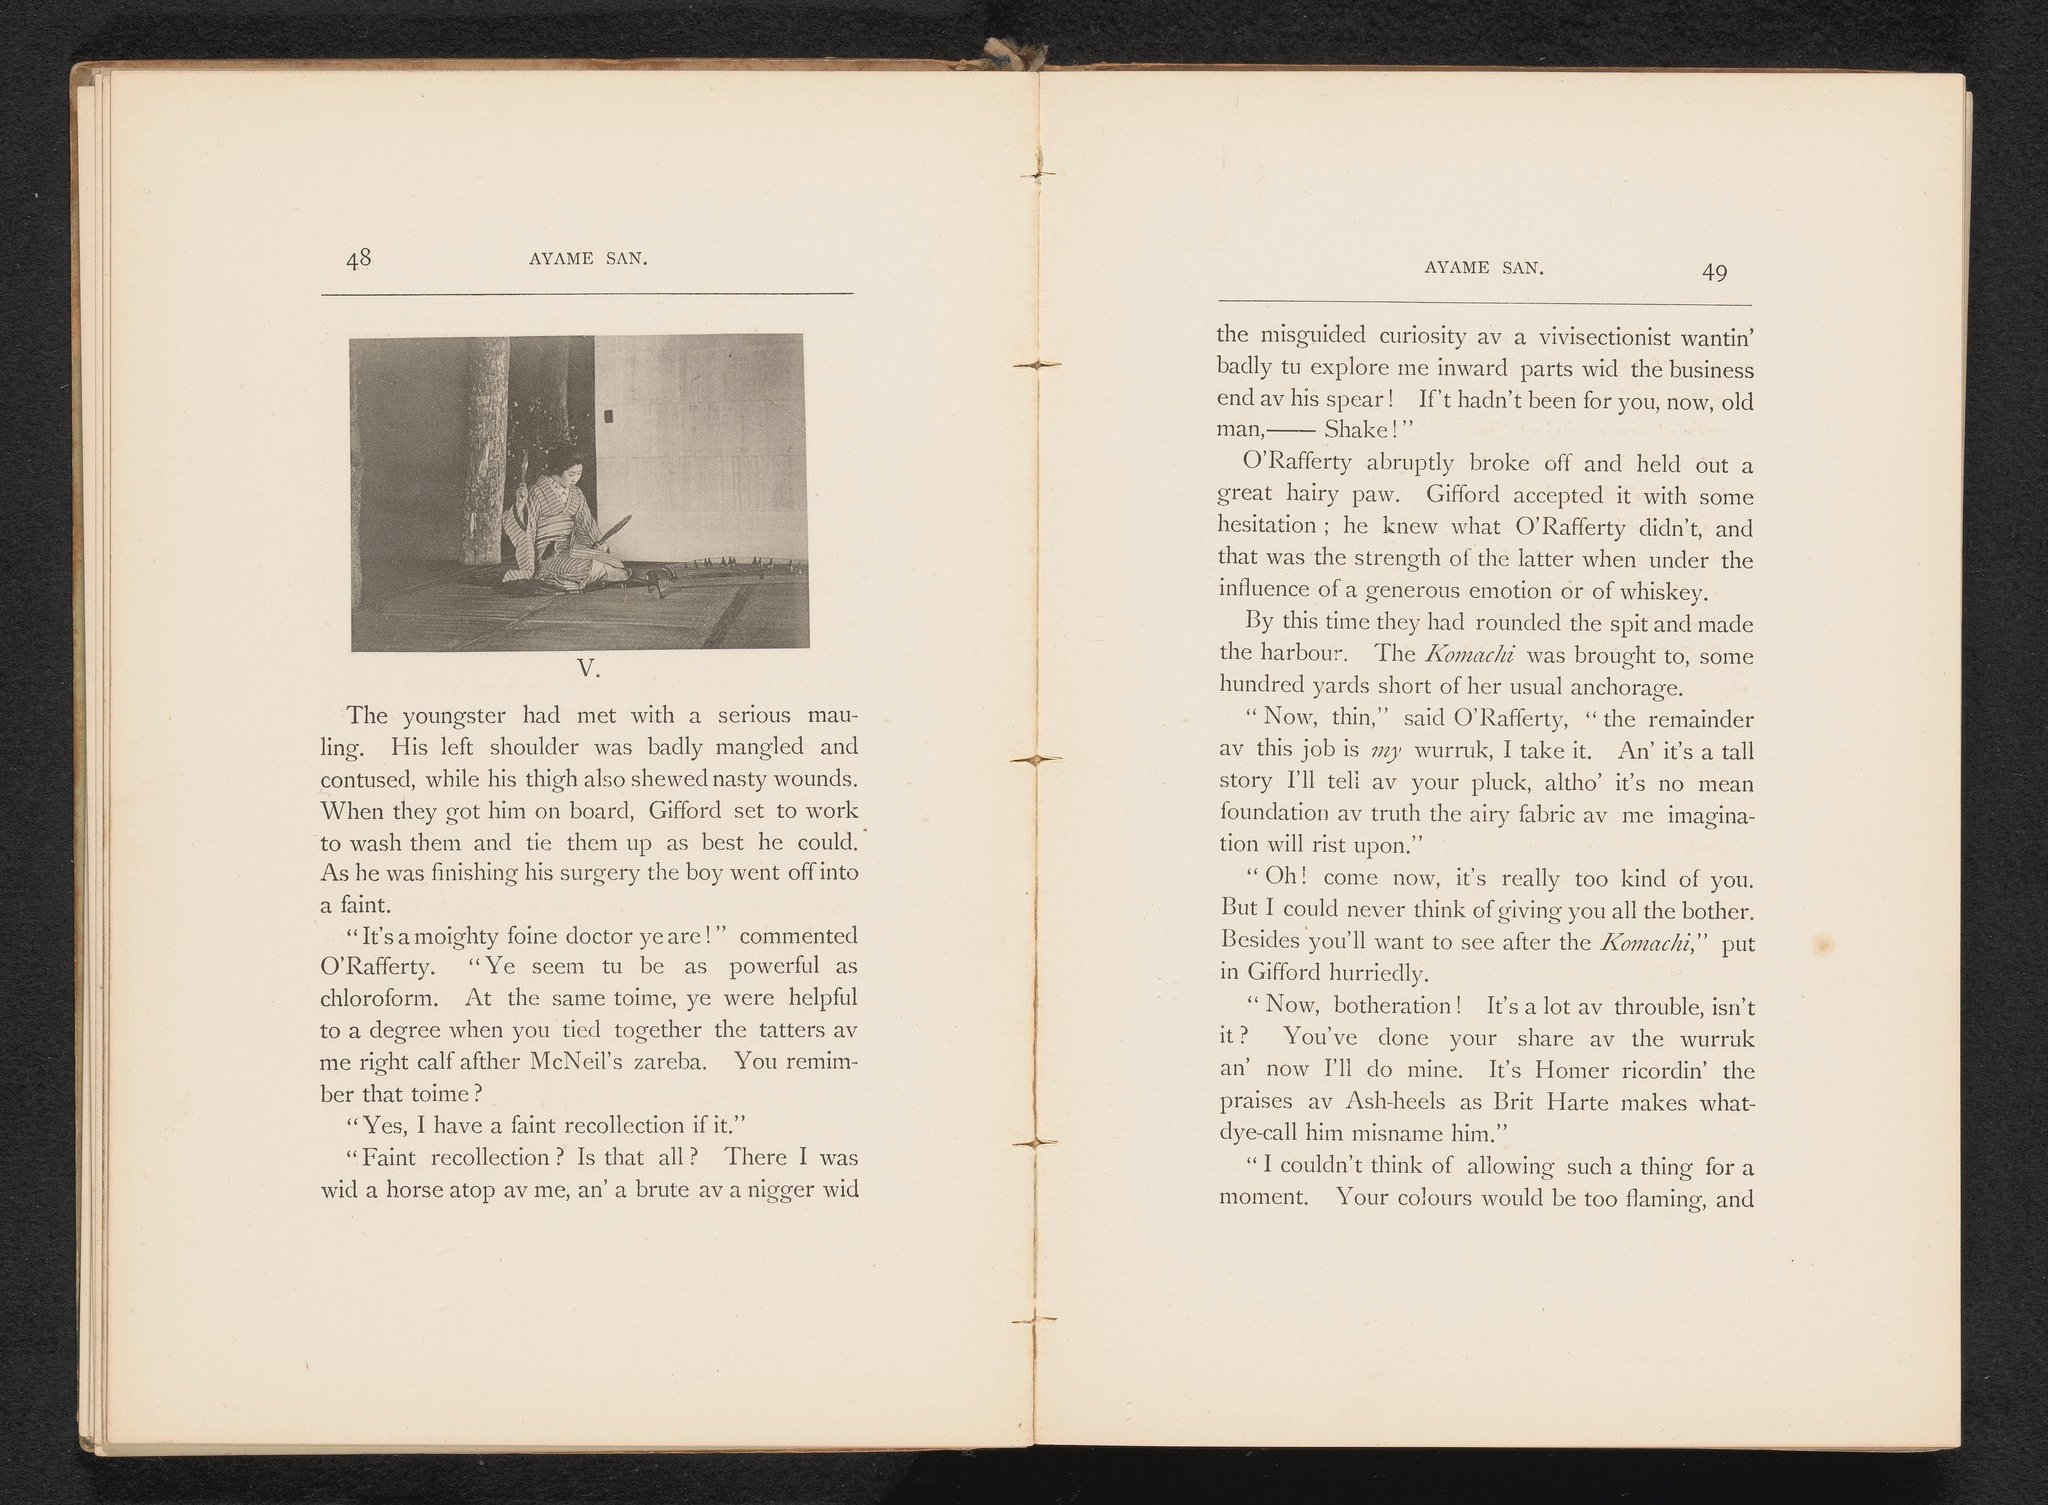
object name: photomechanical print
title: Zittende vrouw met een koto in een interieur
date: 1882-1892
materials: paper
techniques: photograph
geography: japan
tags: interior of the house, string instruments (plucked), sitting on the ground